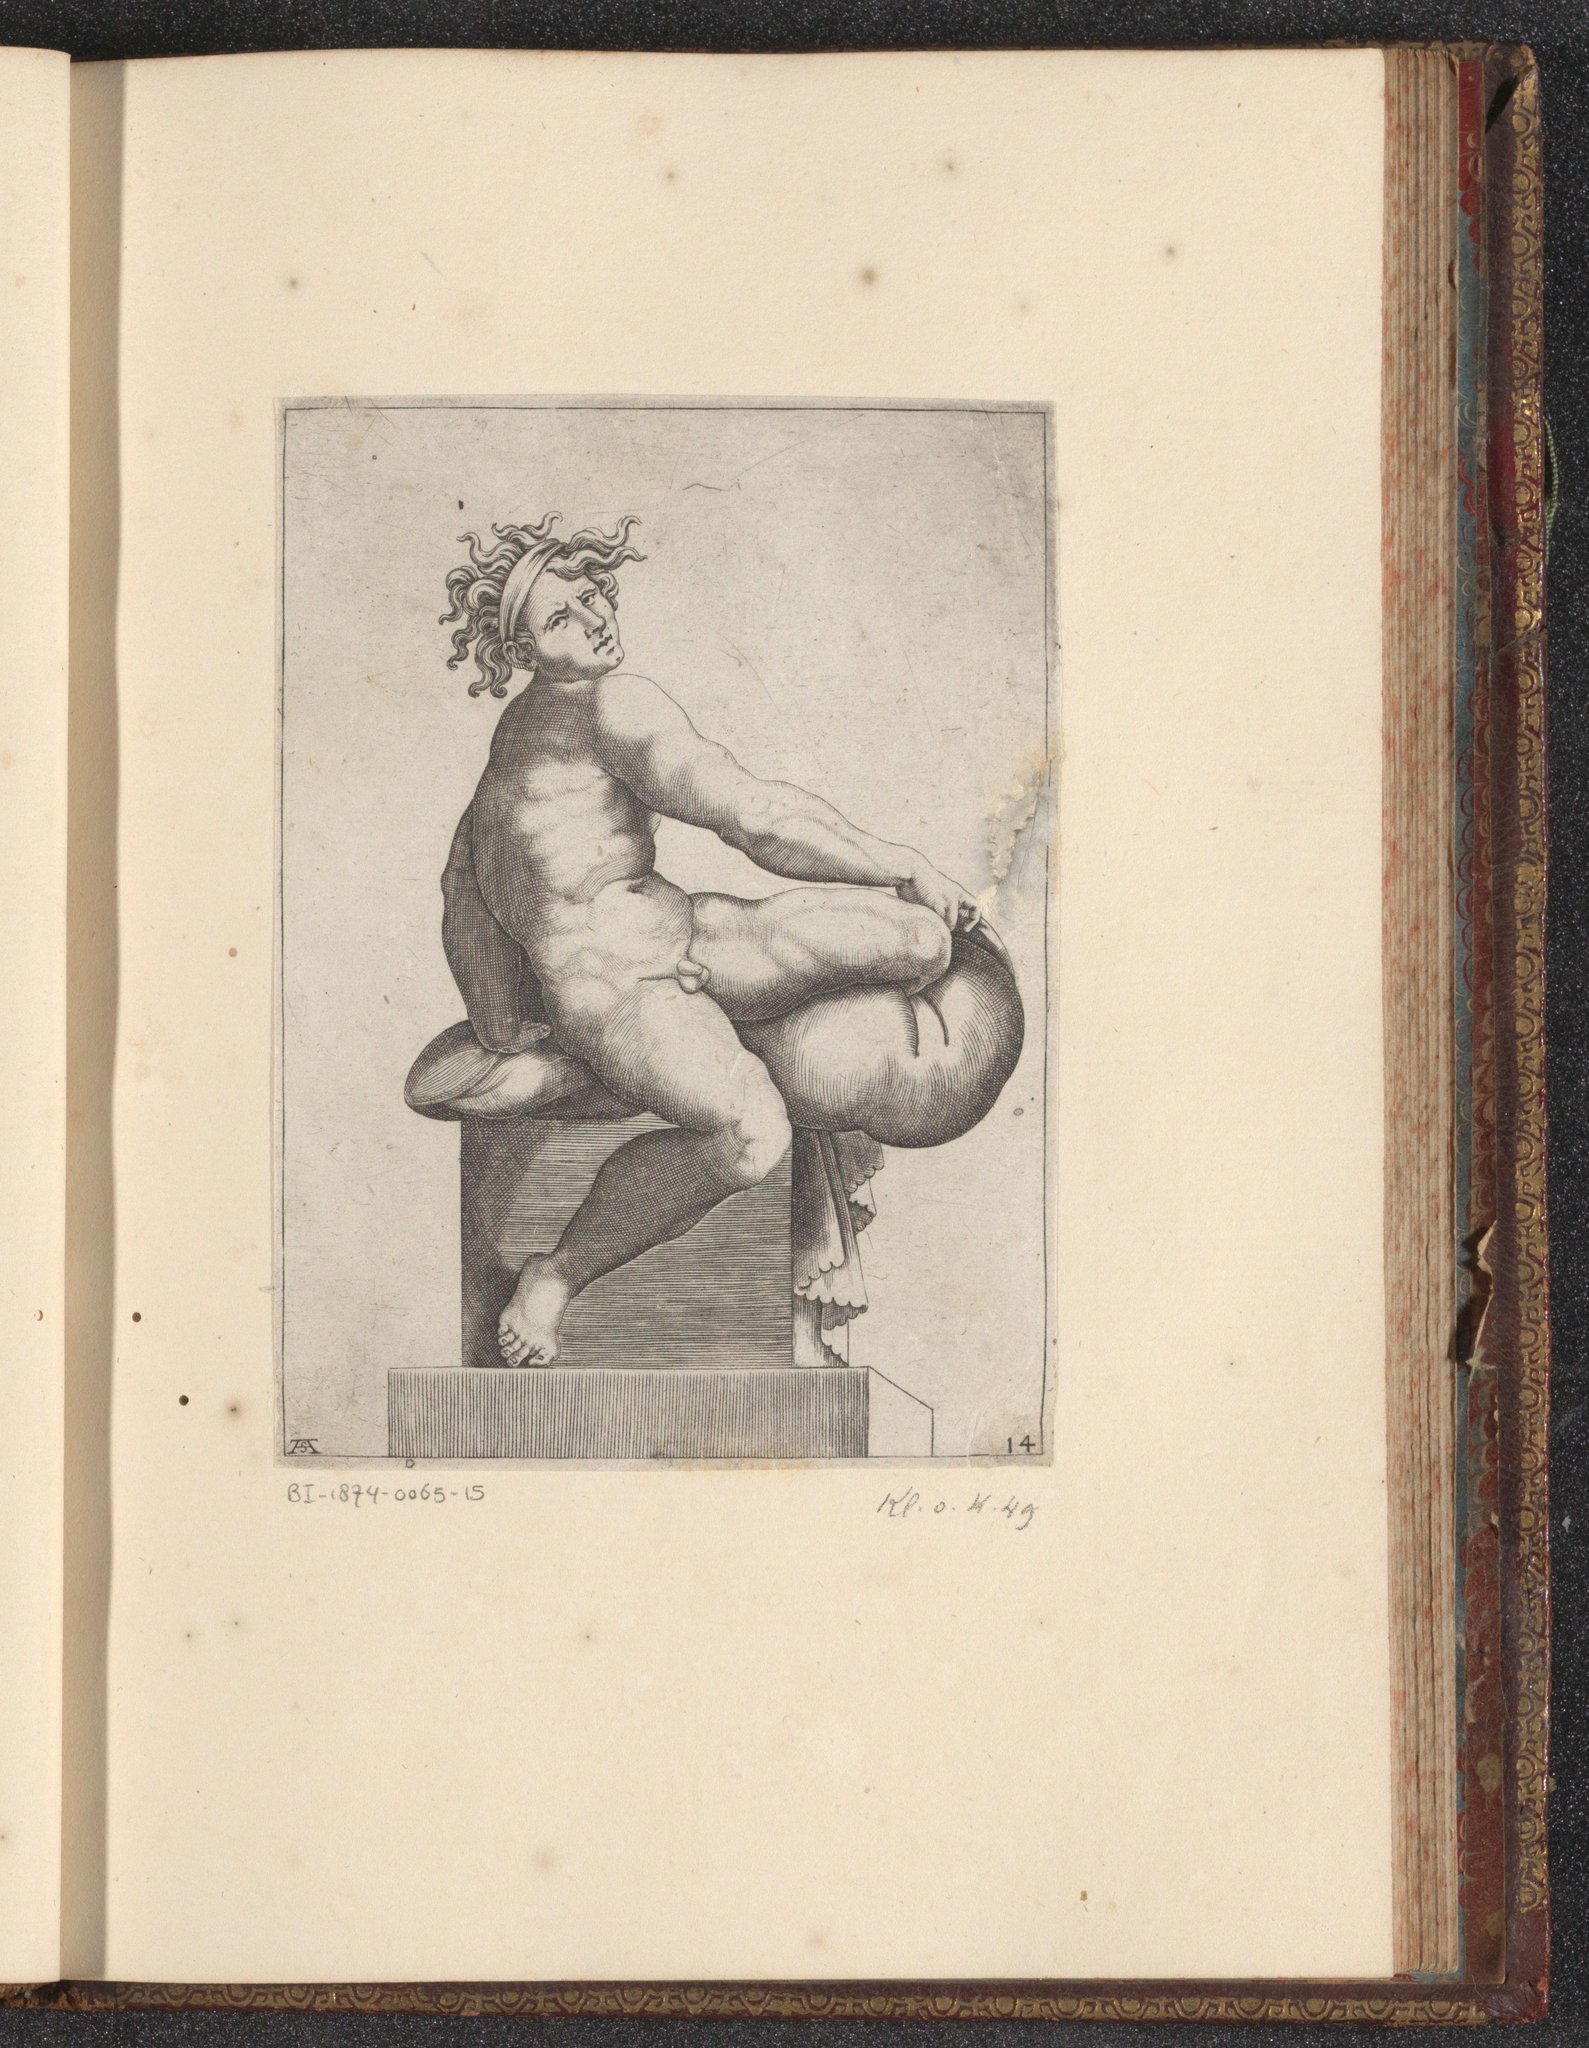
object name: album leaf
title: Schilderingen in de Sixtijnse kapel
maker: adamo scultori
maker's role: painter, print maker, sculptor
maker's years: 1530-1585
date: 1585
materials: paper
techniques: engraving, intaglio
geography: vatican city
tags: the (nude) human figure; 'corpo humano' (ripa)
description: Naakte man zittend op een kussen, naar rechts gedraaid. Eén van de 'ignudi' (naakte mannen) van Michelangelo's plafondschildering. Genummerd rechtsonder: 14. De prent maakt deel uit van een album.